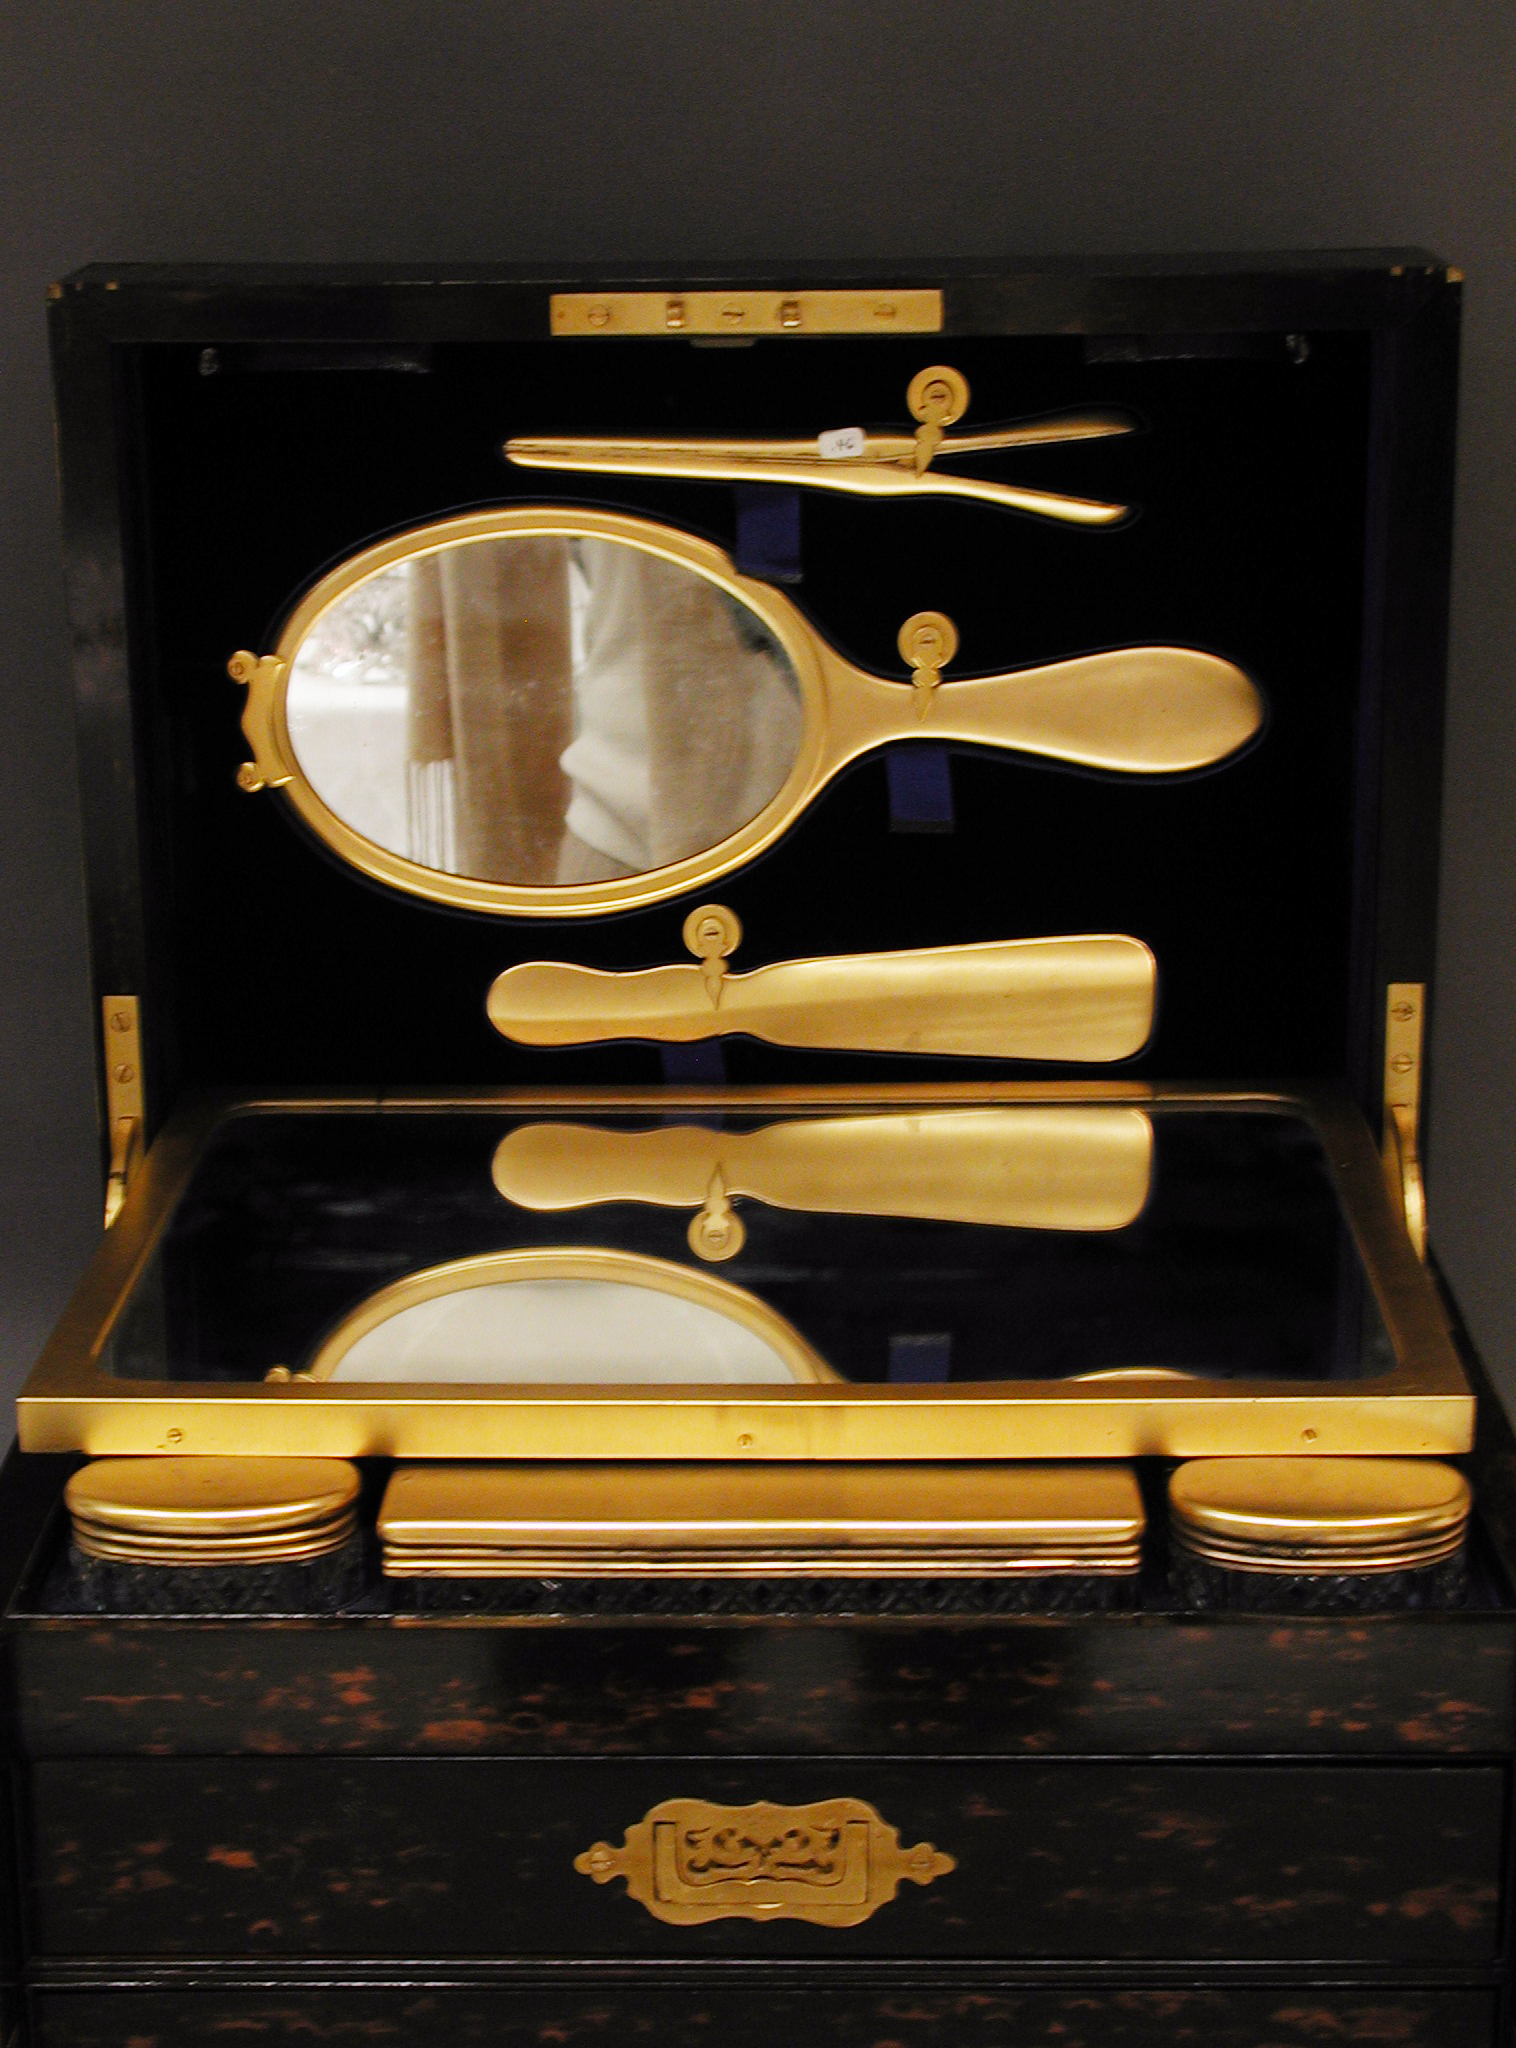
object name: hand mirror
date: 1874-1875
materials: glass, silver